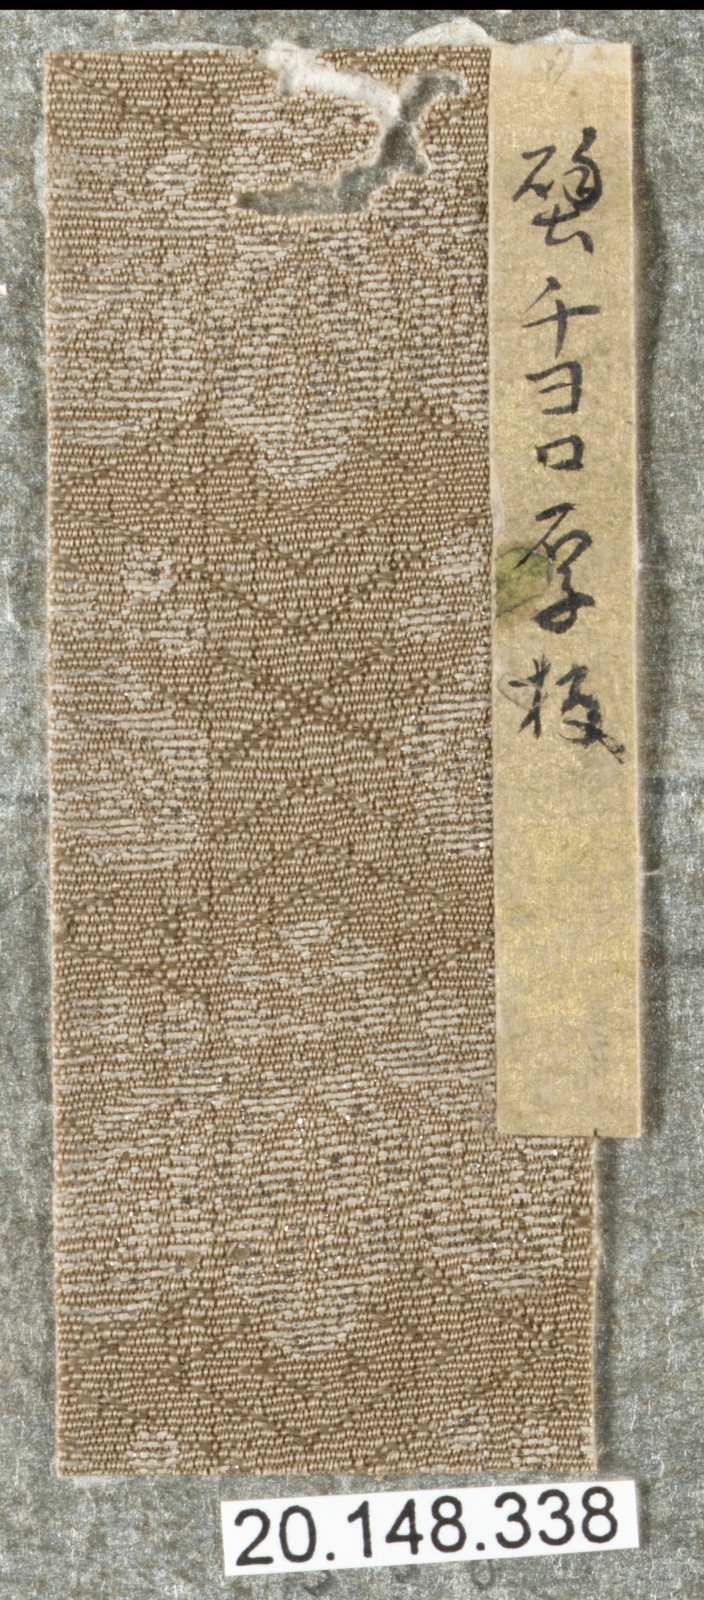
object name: piece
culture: japanese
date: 1701-1800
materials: silk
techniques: compound weave